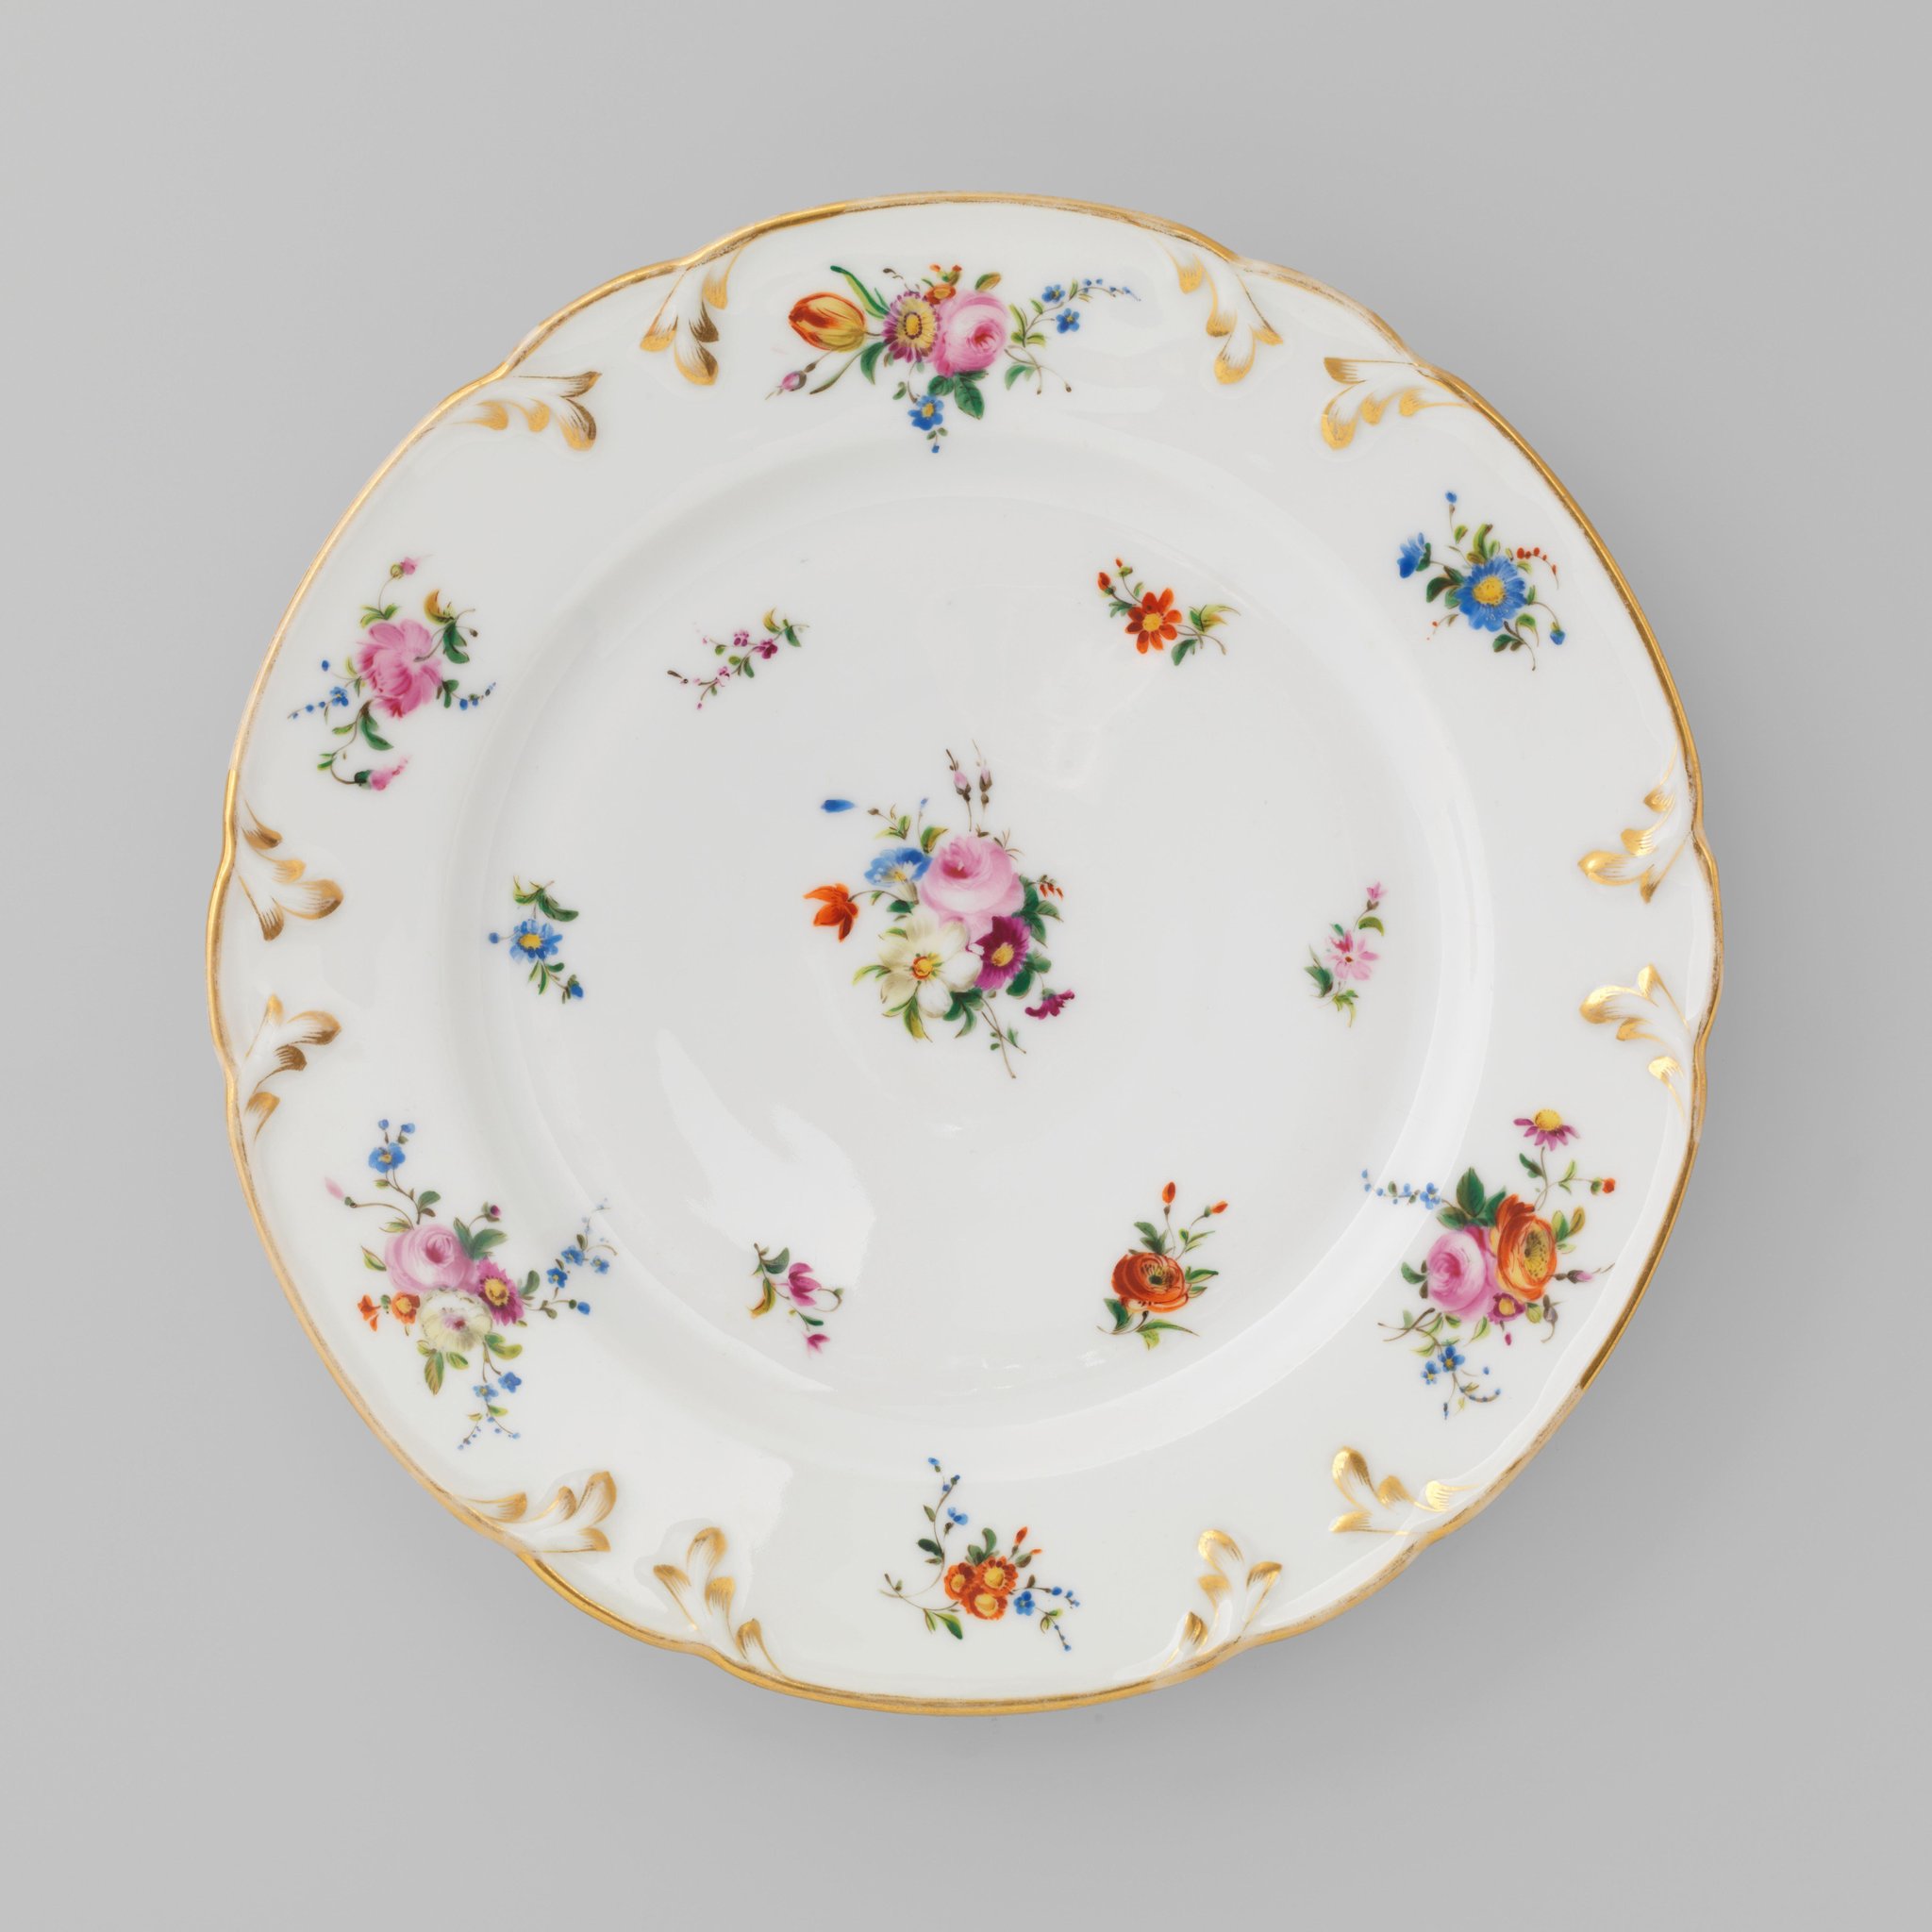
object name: plate dish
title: Plate with bouquets and flower sprays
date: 1839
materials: glaze, gold, paint, porcelain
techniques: firing, forming, gilding, turning, vitrification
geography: paris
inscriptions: mark: ‘32/ X’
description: Bord van porselein met een gelobde rand, beschilderd op het glazuur in blauw, rood, roze, groen, geel, paars, zwart en goud. Op het plat boeketten van verschillende bloemen en strooibloemen. Vanuit de gelobde, gouden rand, gemodelleerde bladranken in reliëf, aangezet met goud. Hiertussen boeketten. Drie proenen op de onderzijde. Gemerkt op de onderzijde met 32 en X.